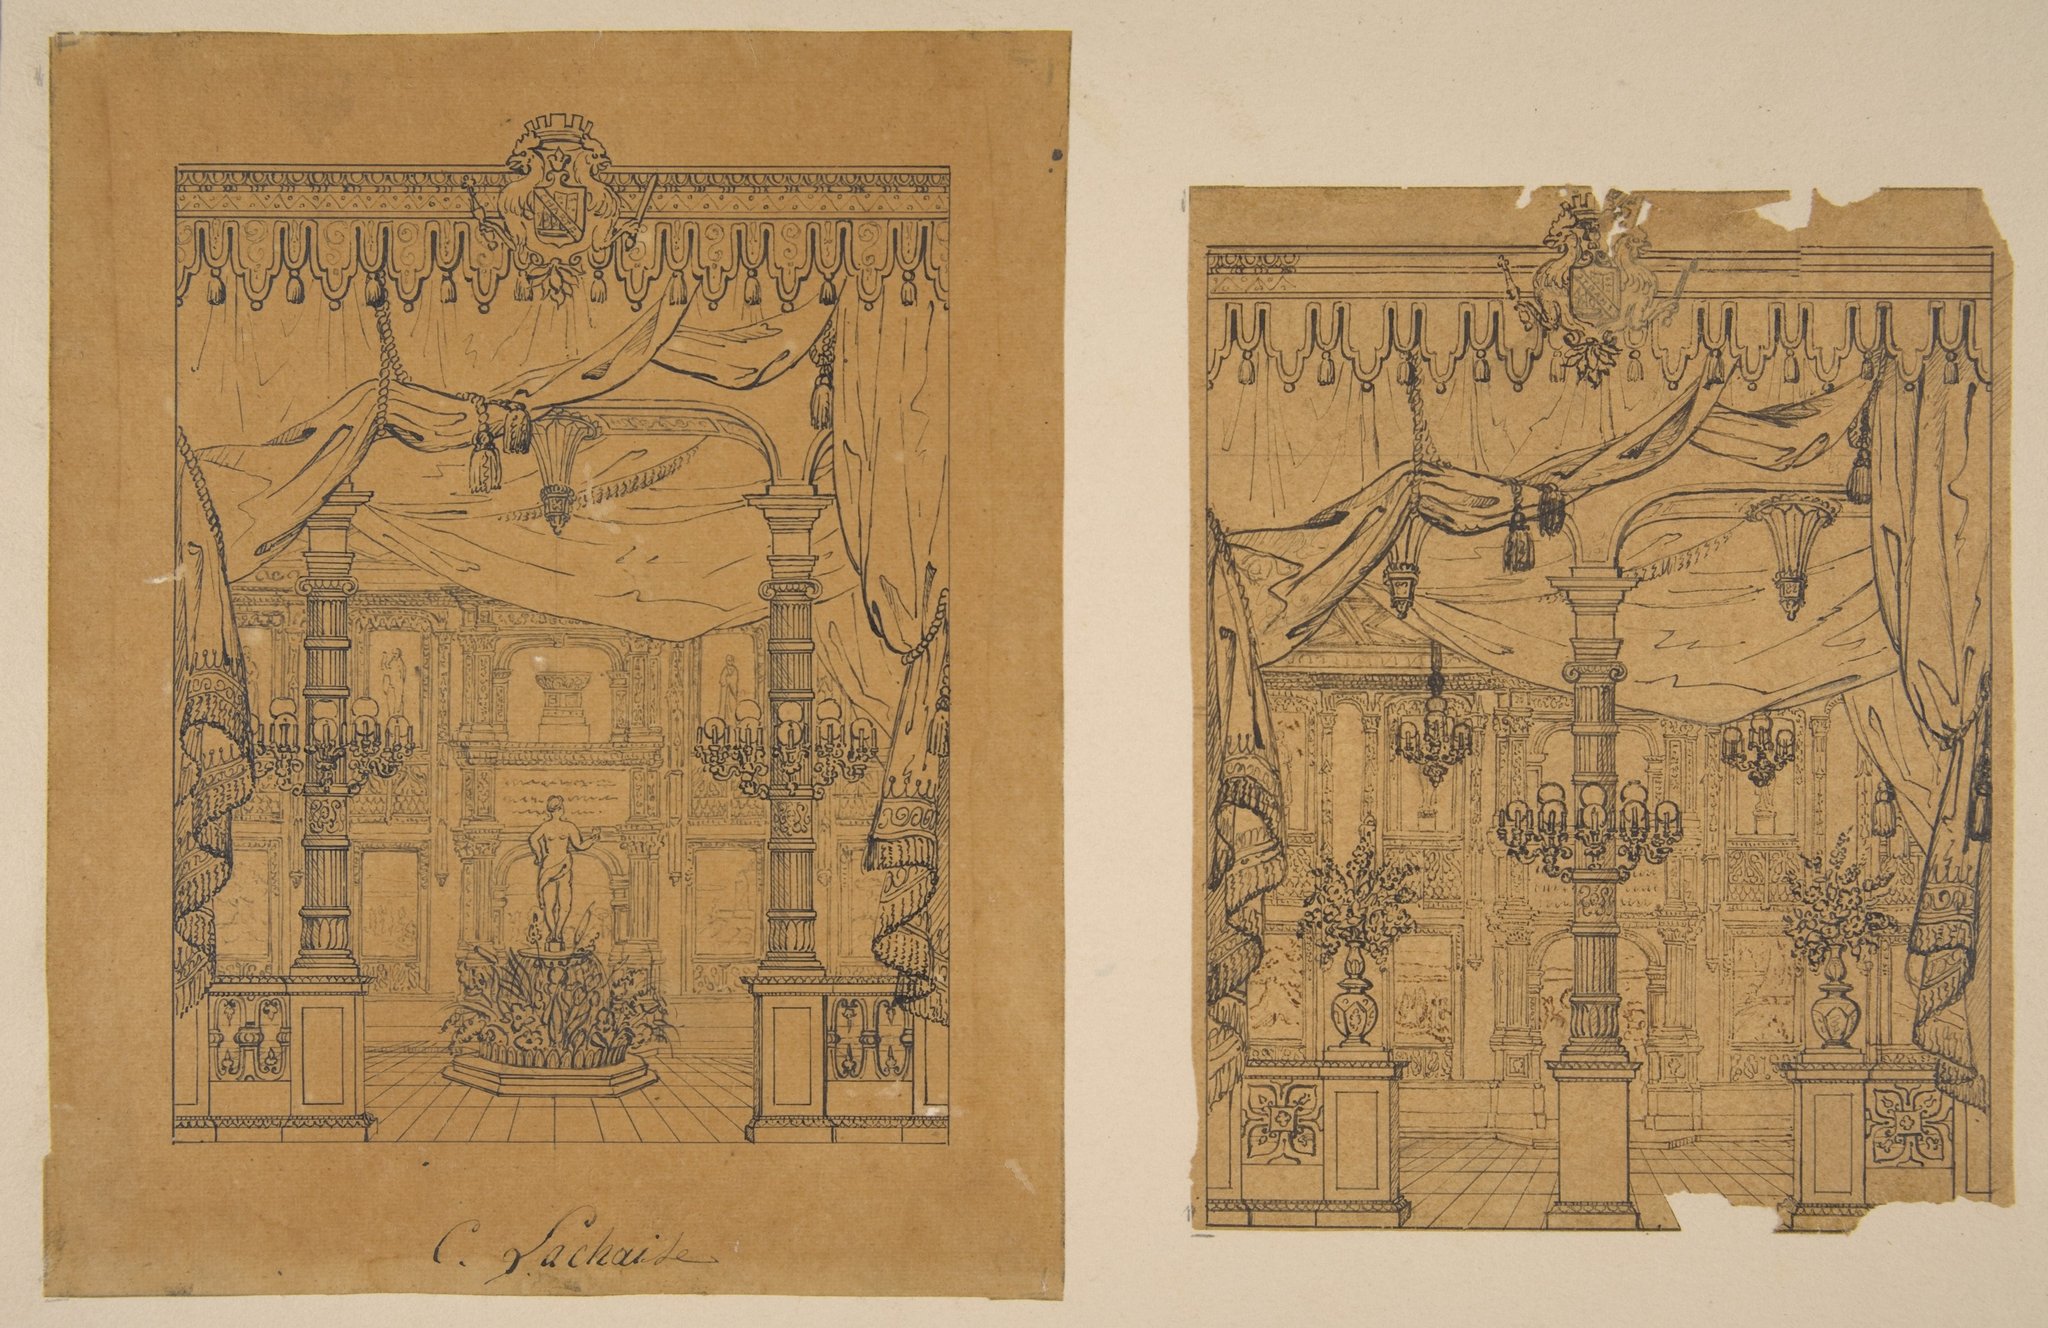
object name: drawing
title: Two Views of a Grand Foyer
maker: jules-edmond-charles lachaise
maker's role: artist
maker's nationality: french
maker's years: 1897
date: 1830-1897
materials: ink, paper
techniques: pen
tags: birds,interiors,coat of arms